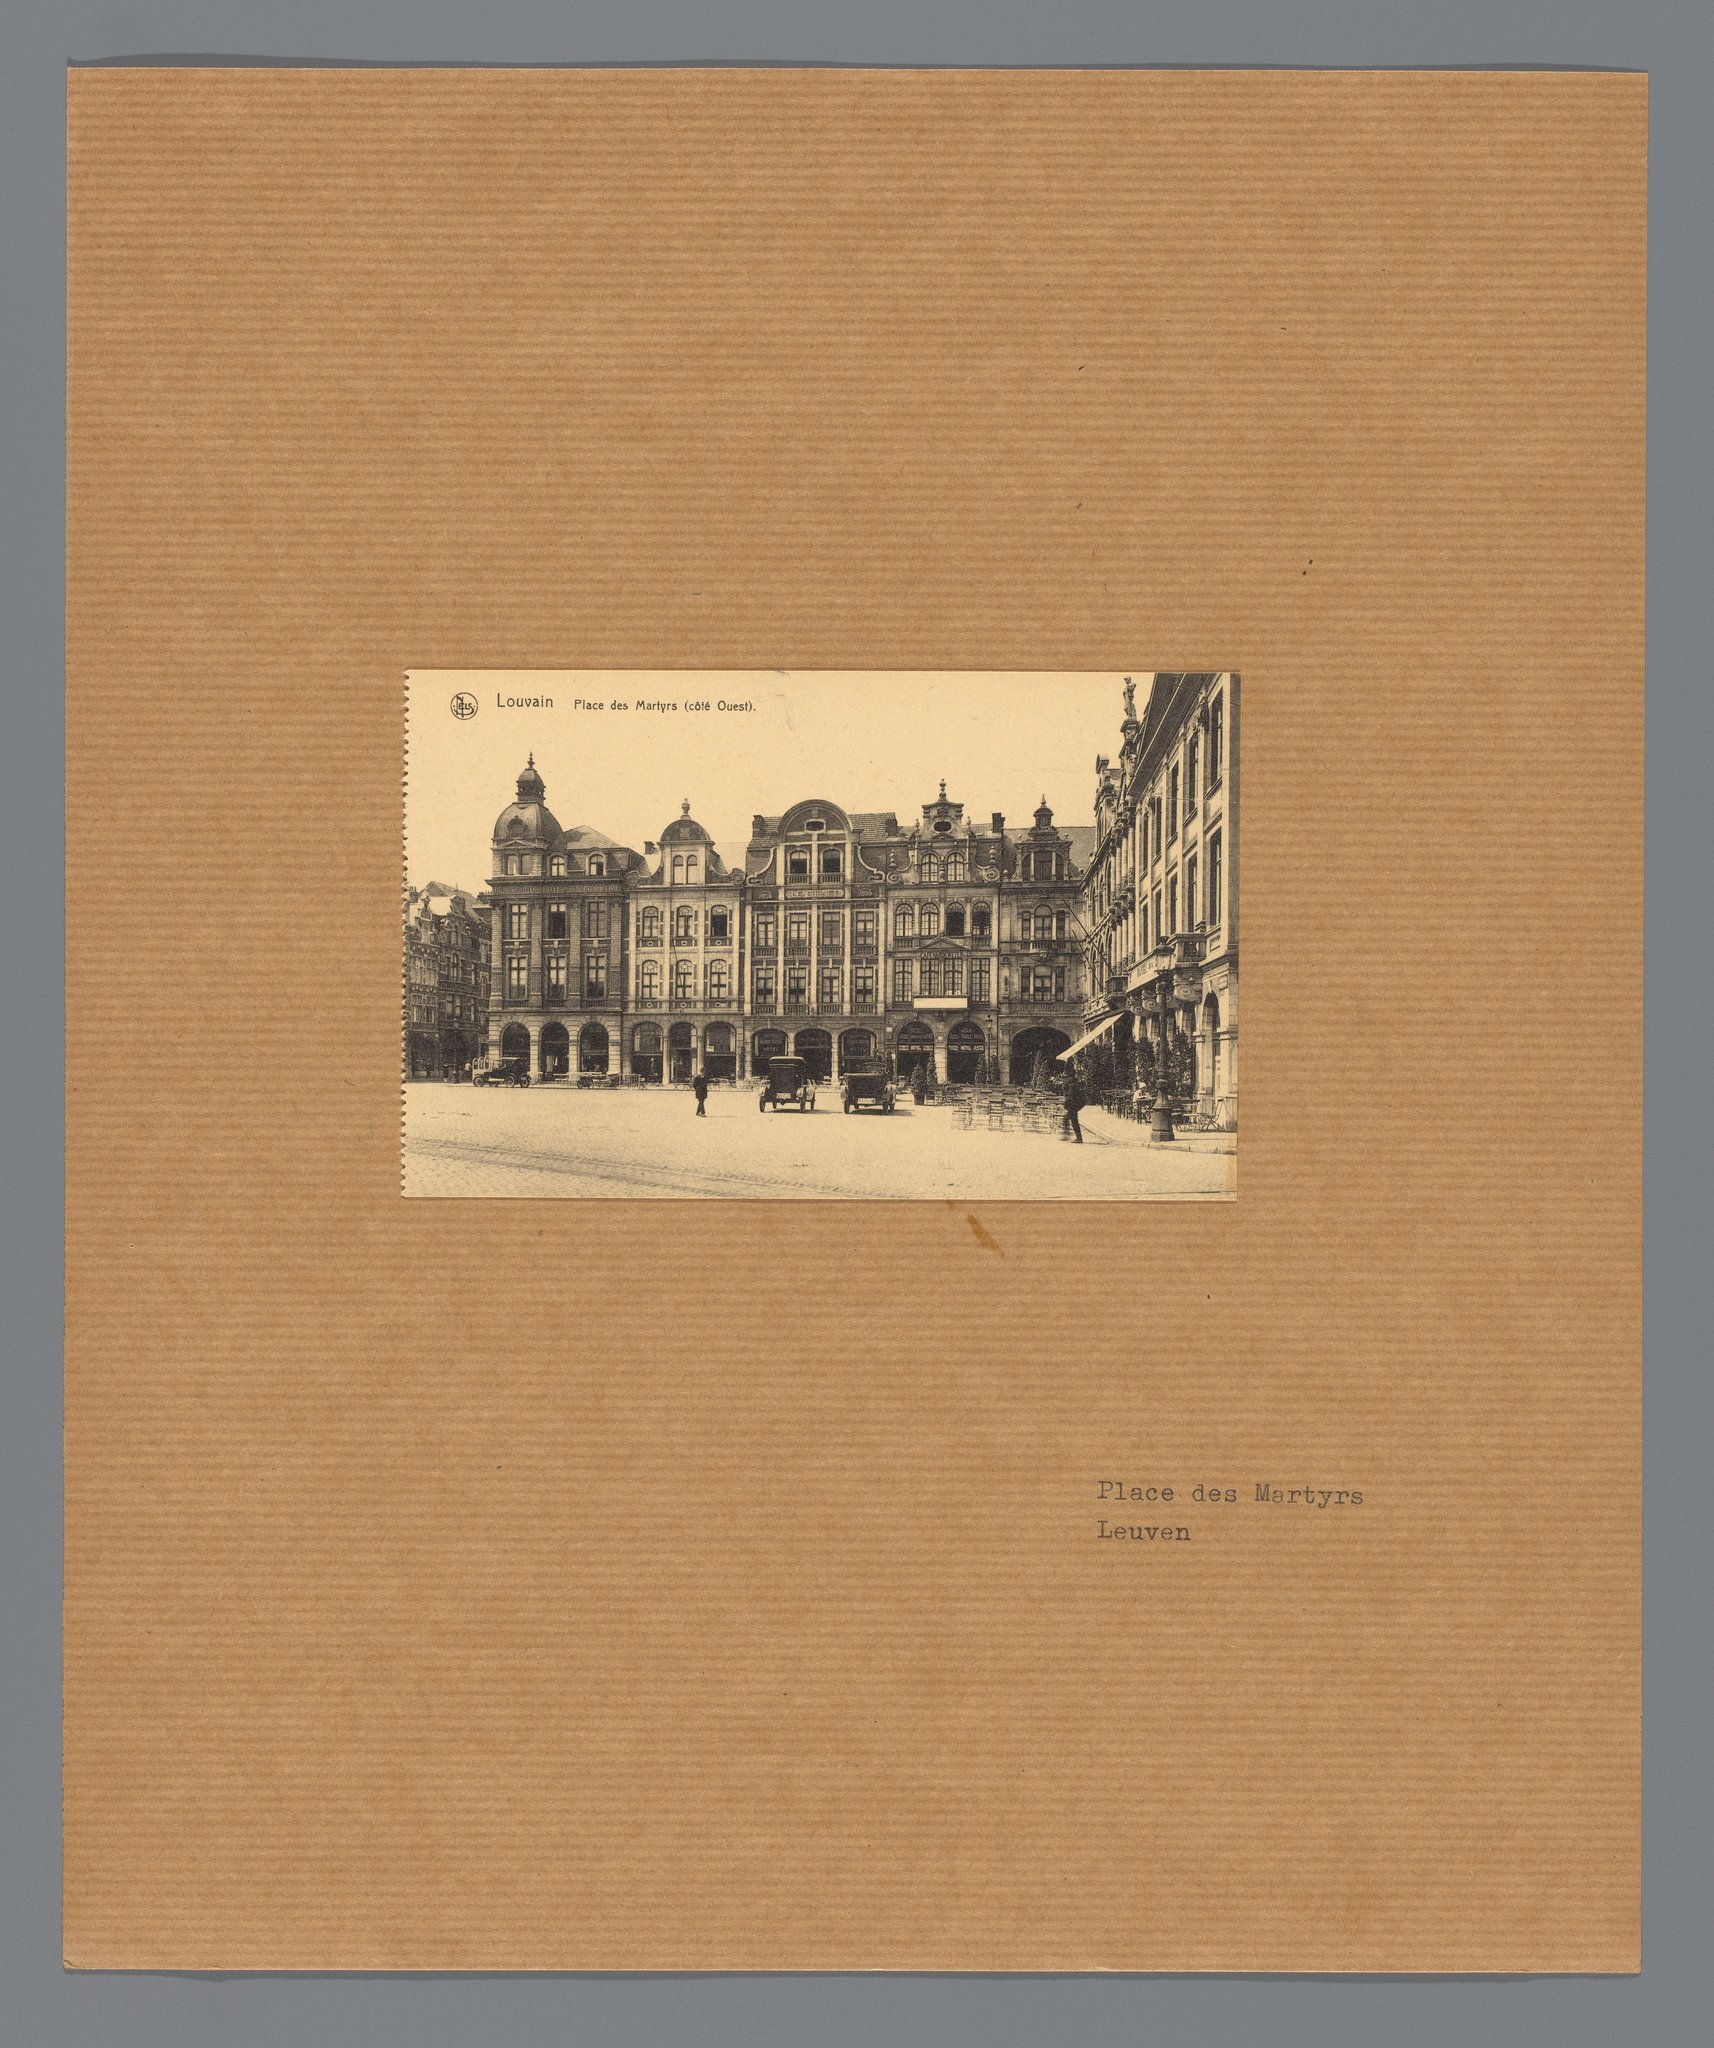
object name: photograph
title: Leuven. Place des Martyrs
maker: Anonymous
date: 1860-1925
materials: photographic support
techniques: photograph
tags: louvain